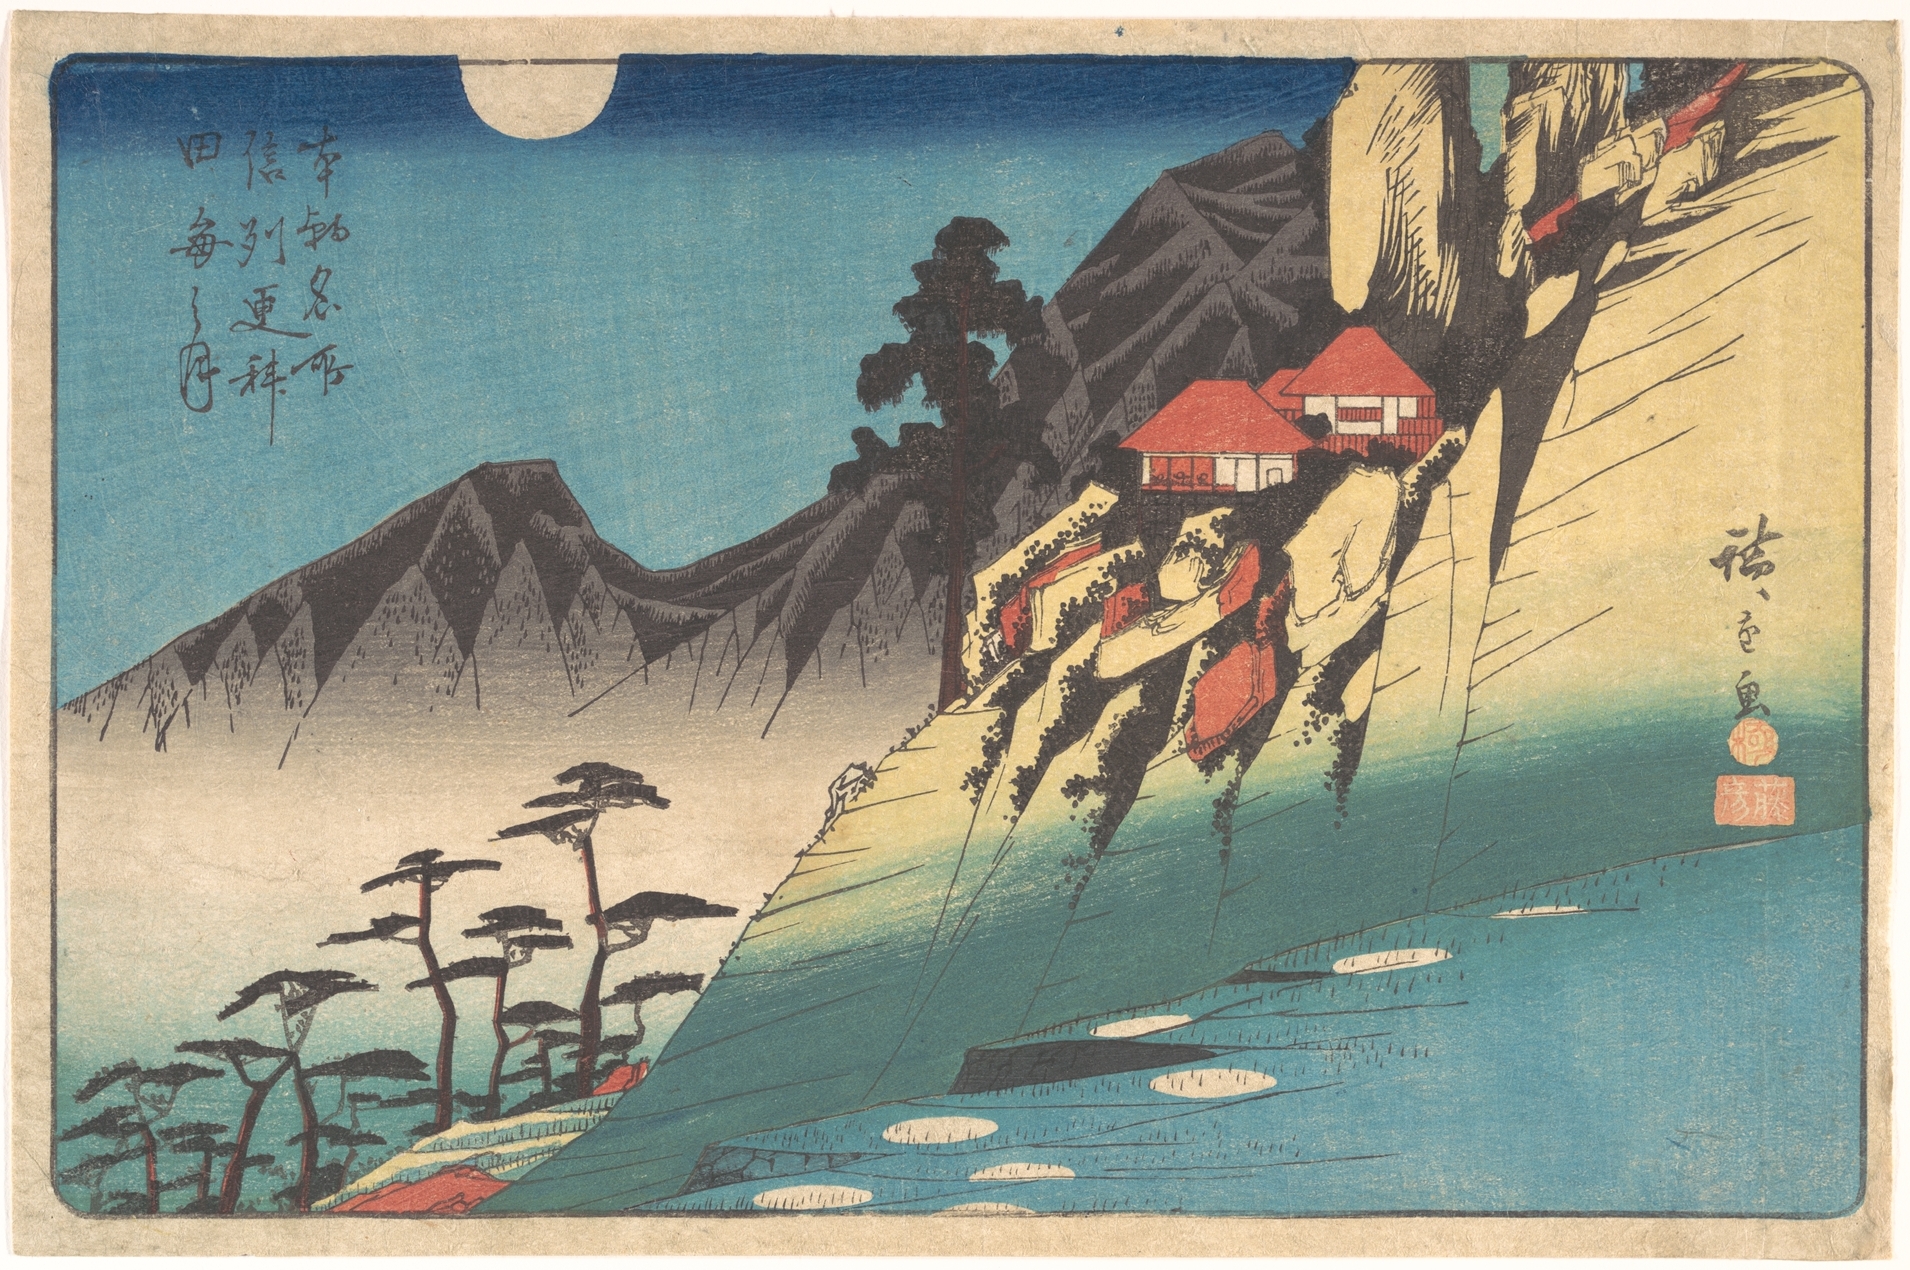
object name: print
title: Reflections of the Moon in the Rice Fields of Sarashina in Shinshu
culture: japanese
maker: utagawa hiroshige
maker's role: artist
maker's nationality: japanese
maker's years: 1797-1858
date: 1832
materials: ink, paper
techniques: woodblock print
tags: moon,hills,landscapes,trees